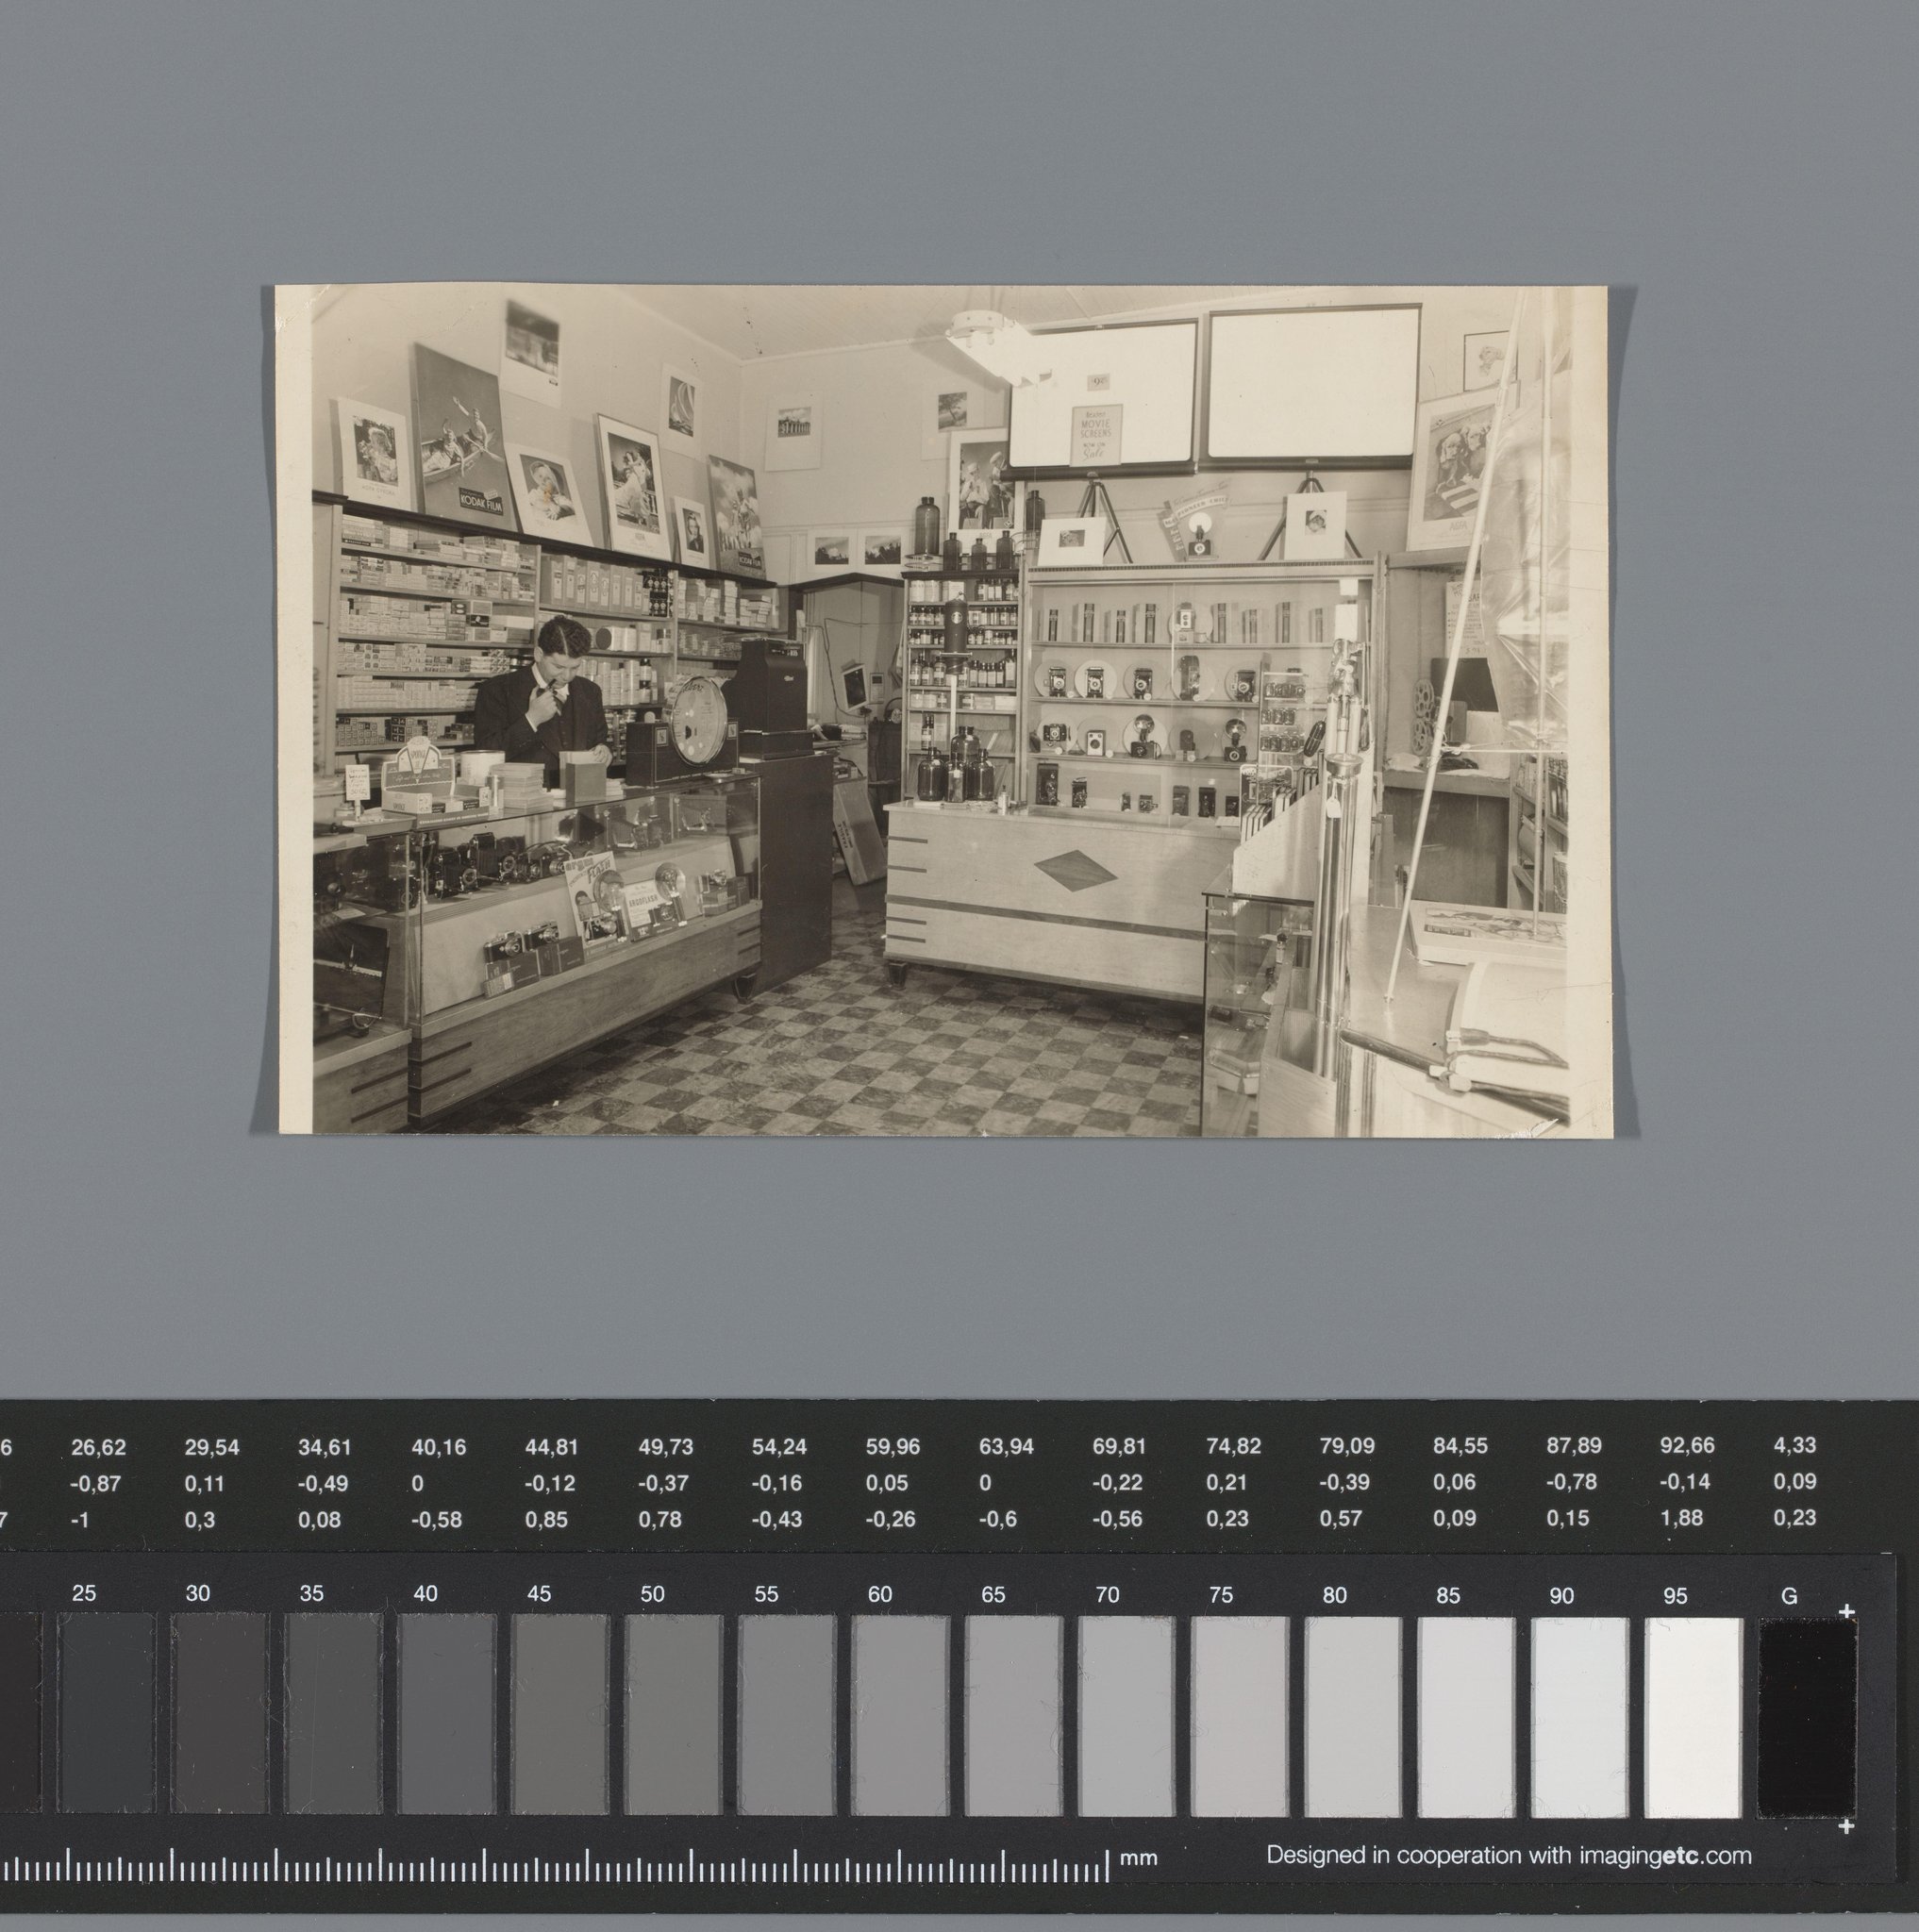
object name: photograph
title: Interieur van de Camera Shop in White Plains, New York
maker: Anonymous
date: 1938-1939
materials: photographic support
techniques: gelatin silver print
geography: united states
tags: white plains, new york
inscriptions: inscription: ‘Camera Shop / probably 1938-39’